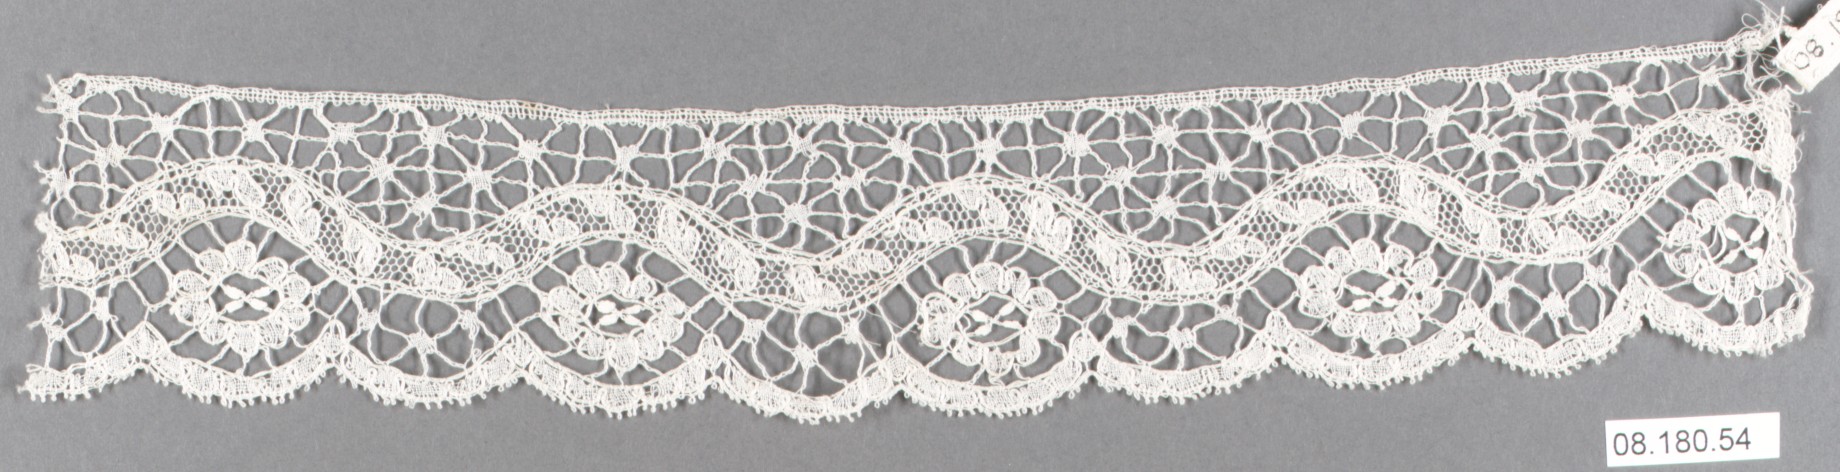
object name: fragment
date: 1801-1900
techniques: lace